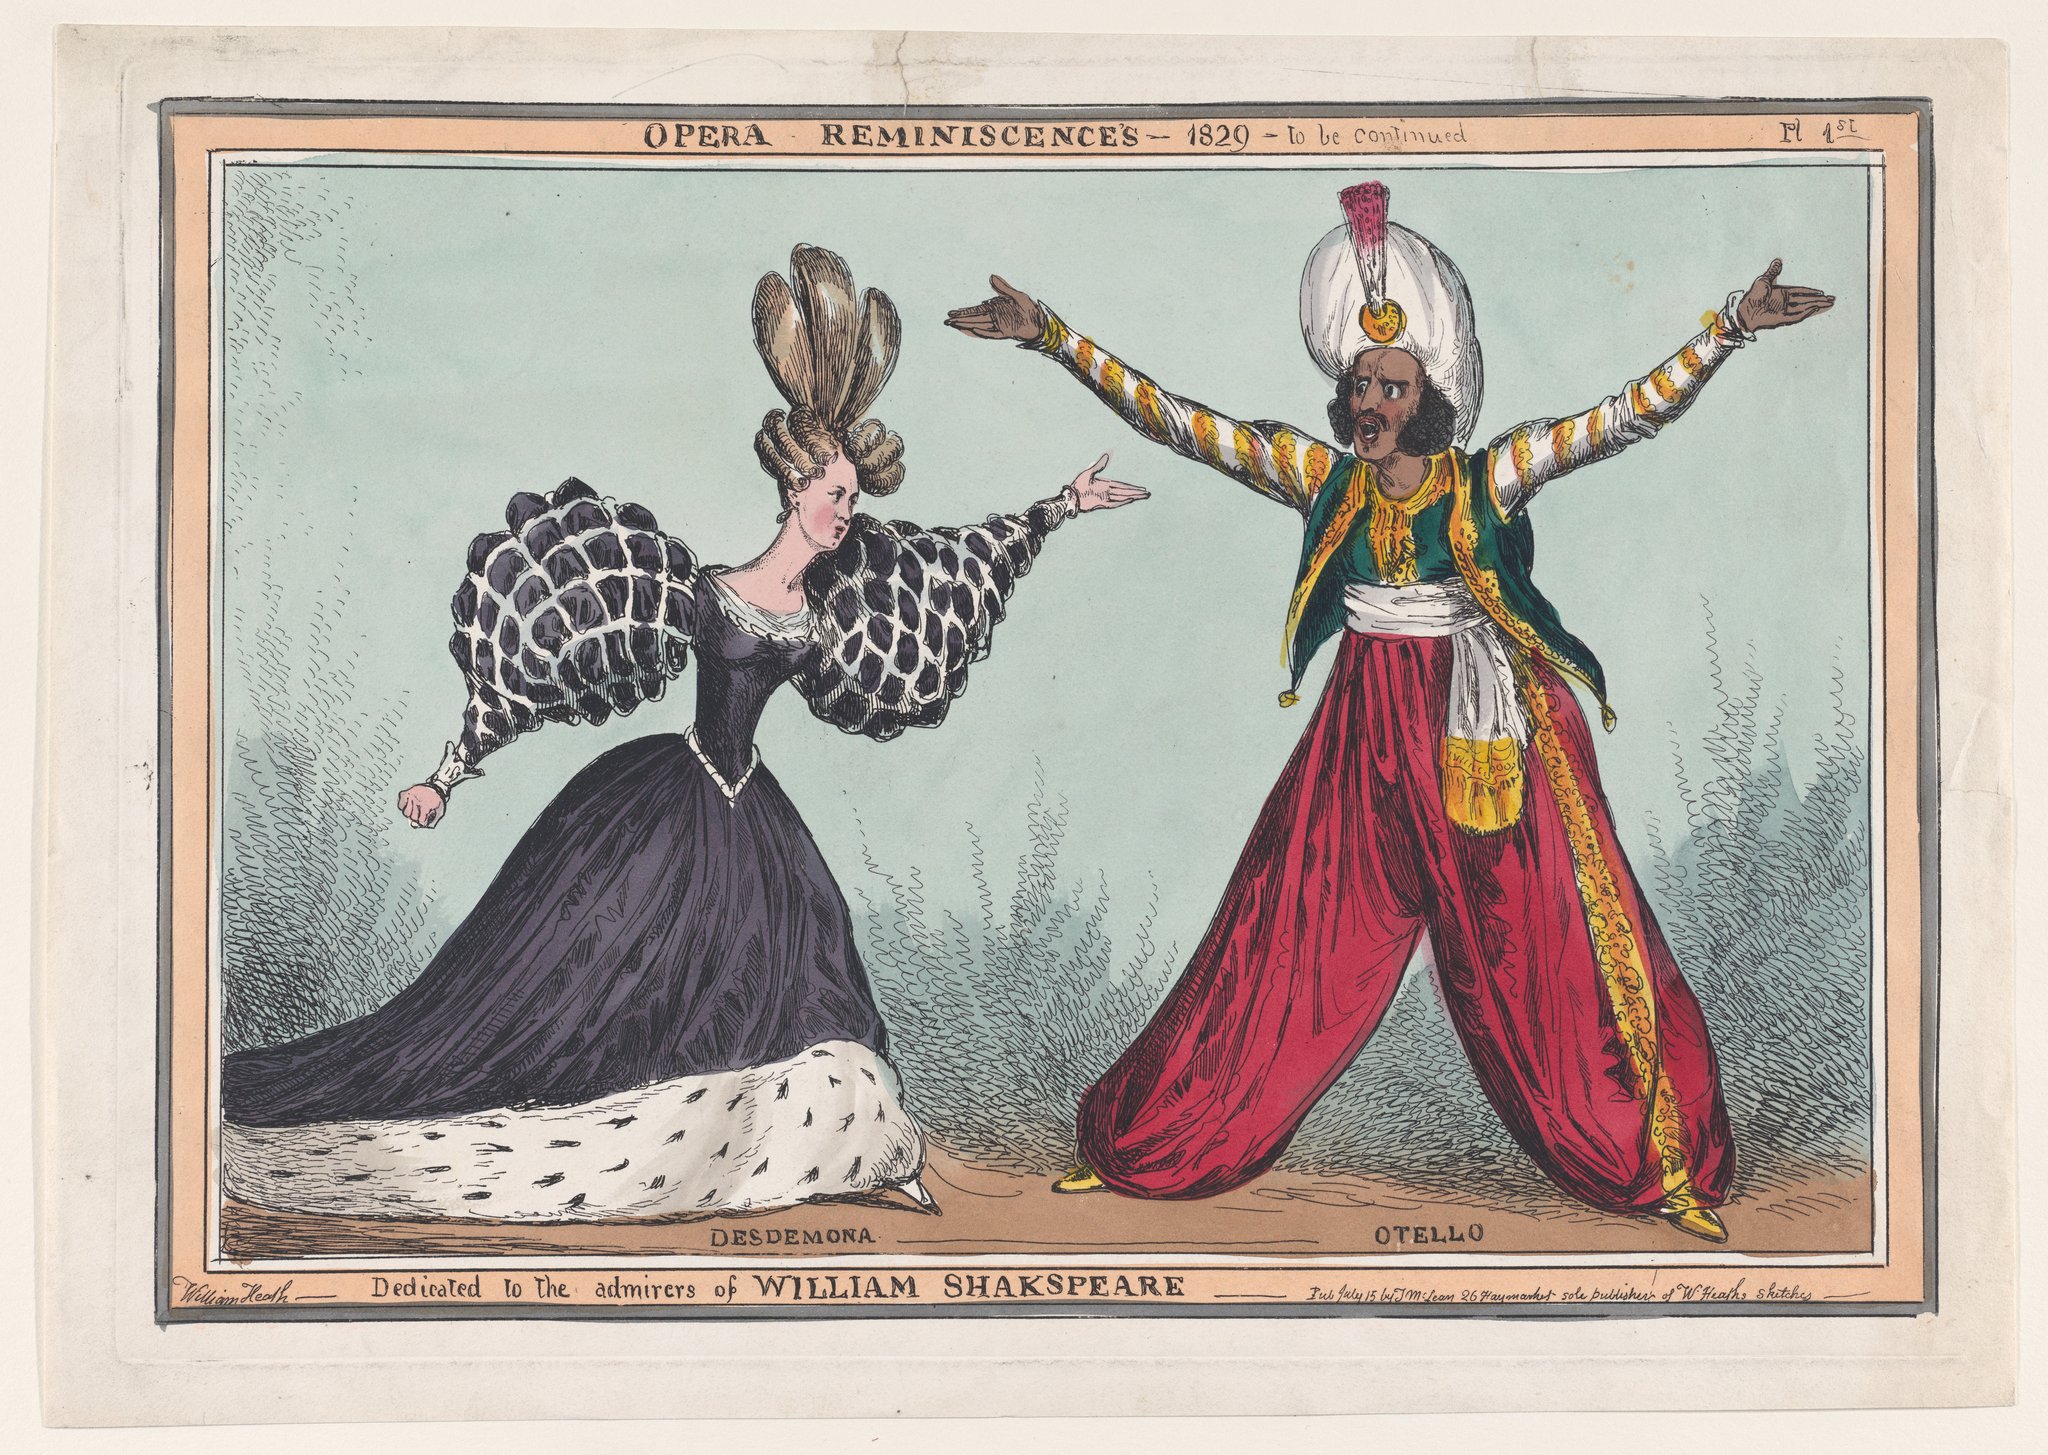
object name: print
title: Opera Reminiscences, Plate 1st: Desdemona and Otello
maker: william heath ('paul pry')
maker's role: artist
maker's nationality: british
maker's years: 1794-1840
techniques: etching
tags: satire,shakespeare,men,women